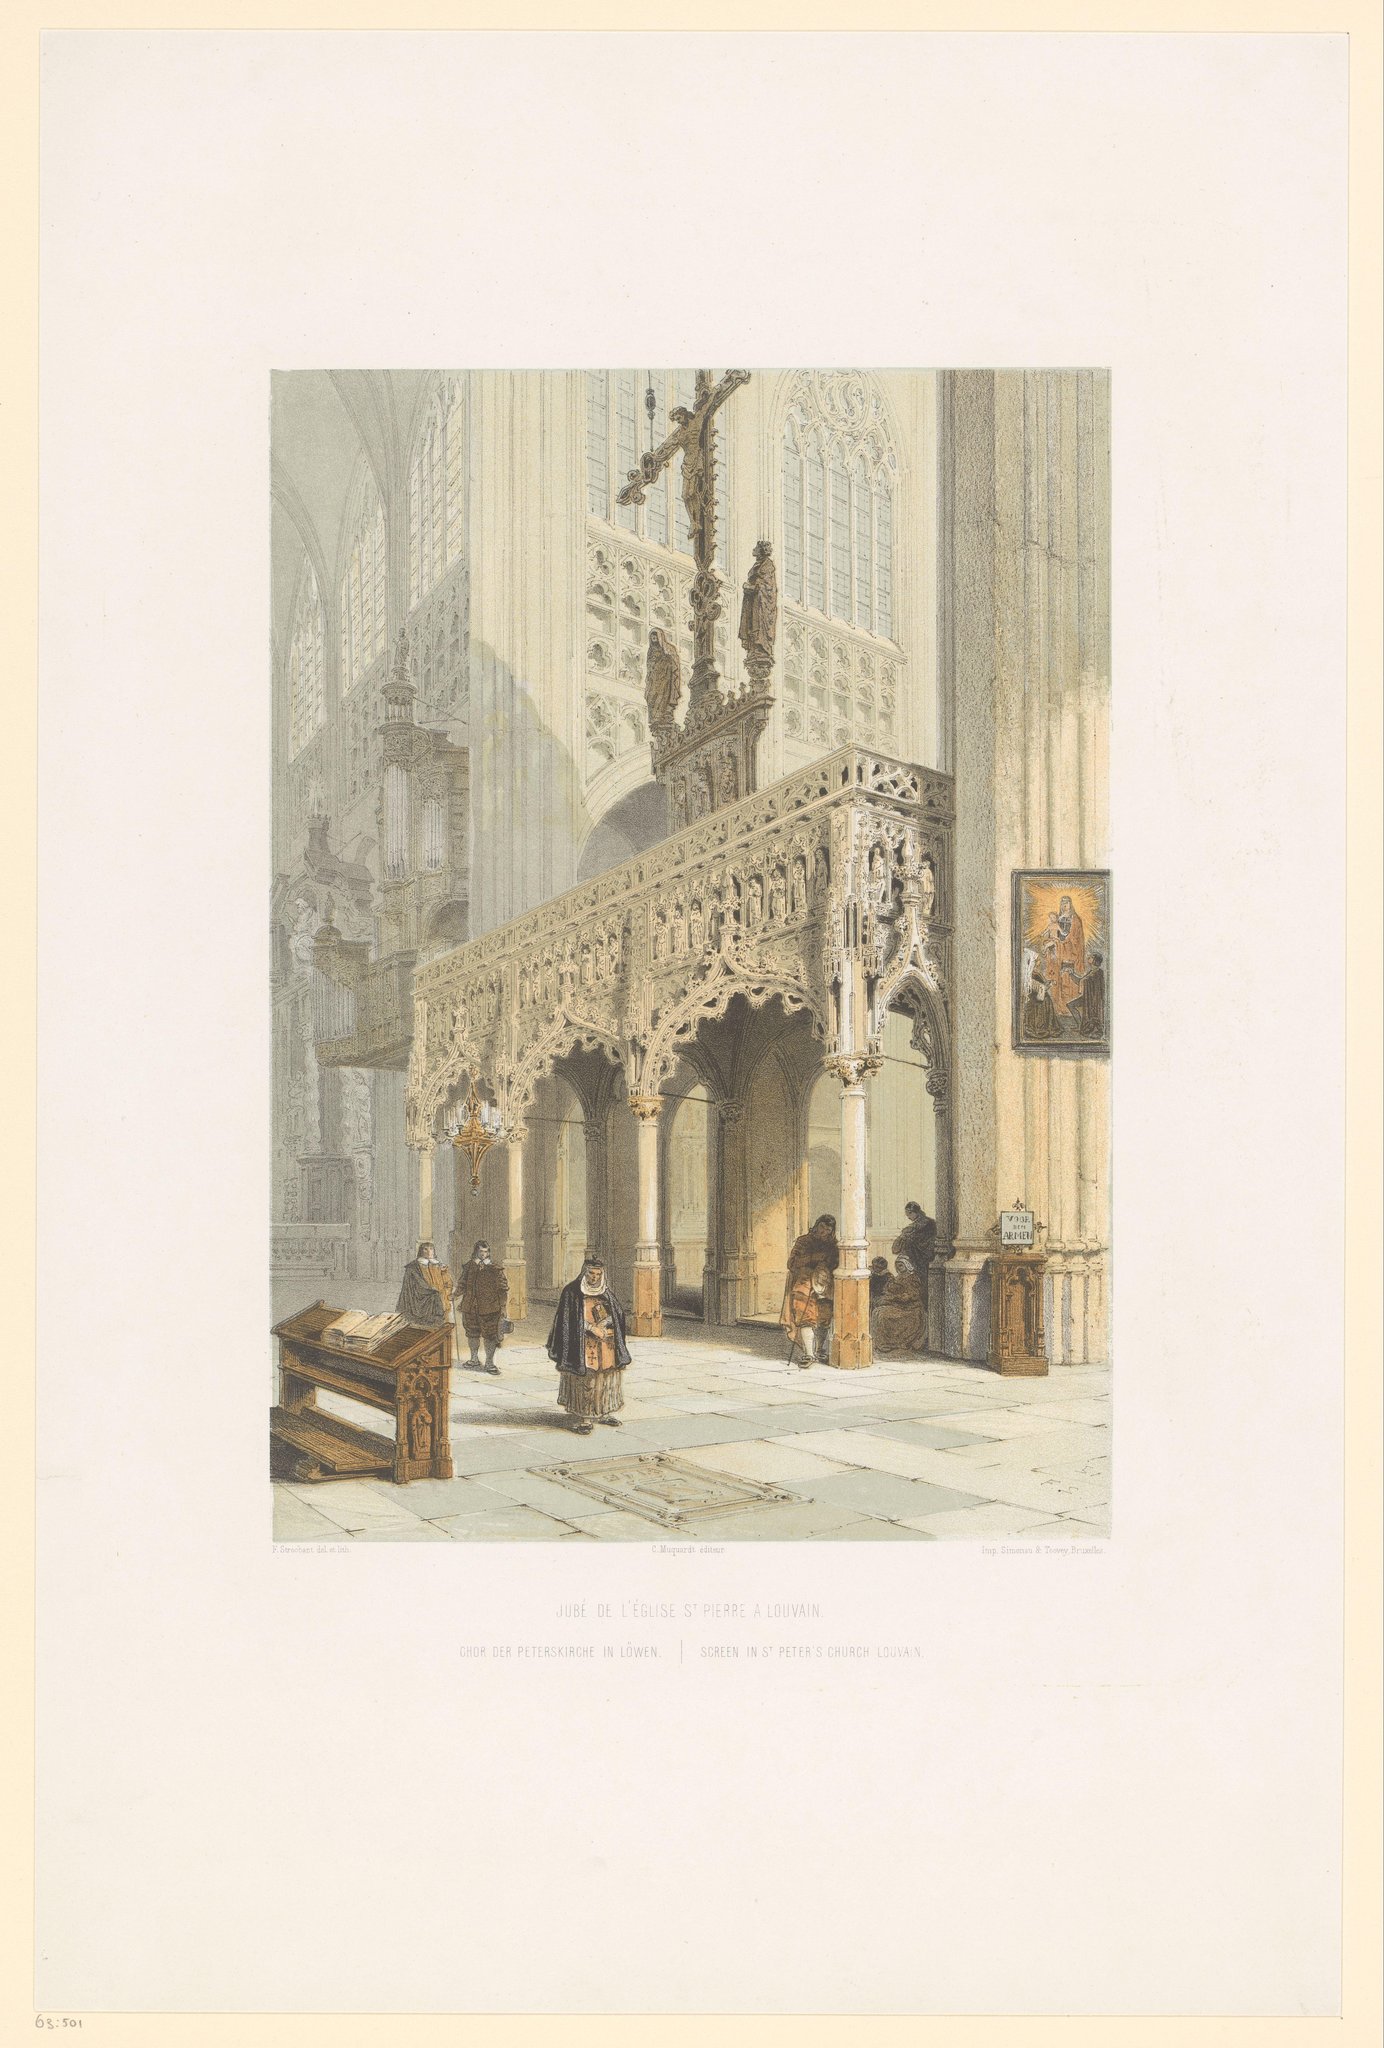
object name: print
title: Oksaal in de Sint-Pieterskerk te Leuven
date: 1852-1878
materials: paper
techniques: lithograph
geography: brussels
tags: interior of church, civic architecture; edifices; dwellings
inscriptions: collector's mark: Lugt 2760, collector's mark: Lugt 2228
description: Vanaf 1852 verschijnen de eerste afleveringen van deze serie, telkens in een set van drie platen voorzien van tekst door Félix Stappaerts. Later (vanaf 1854 tot en met 1878) worden deze prenten gebonden uitgegeven.